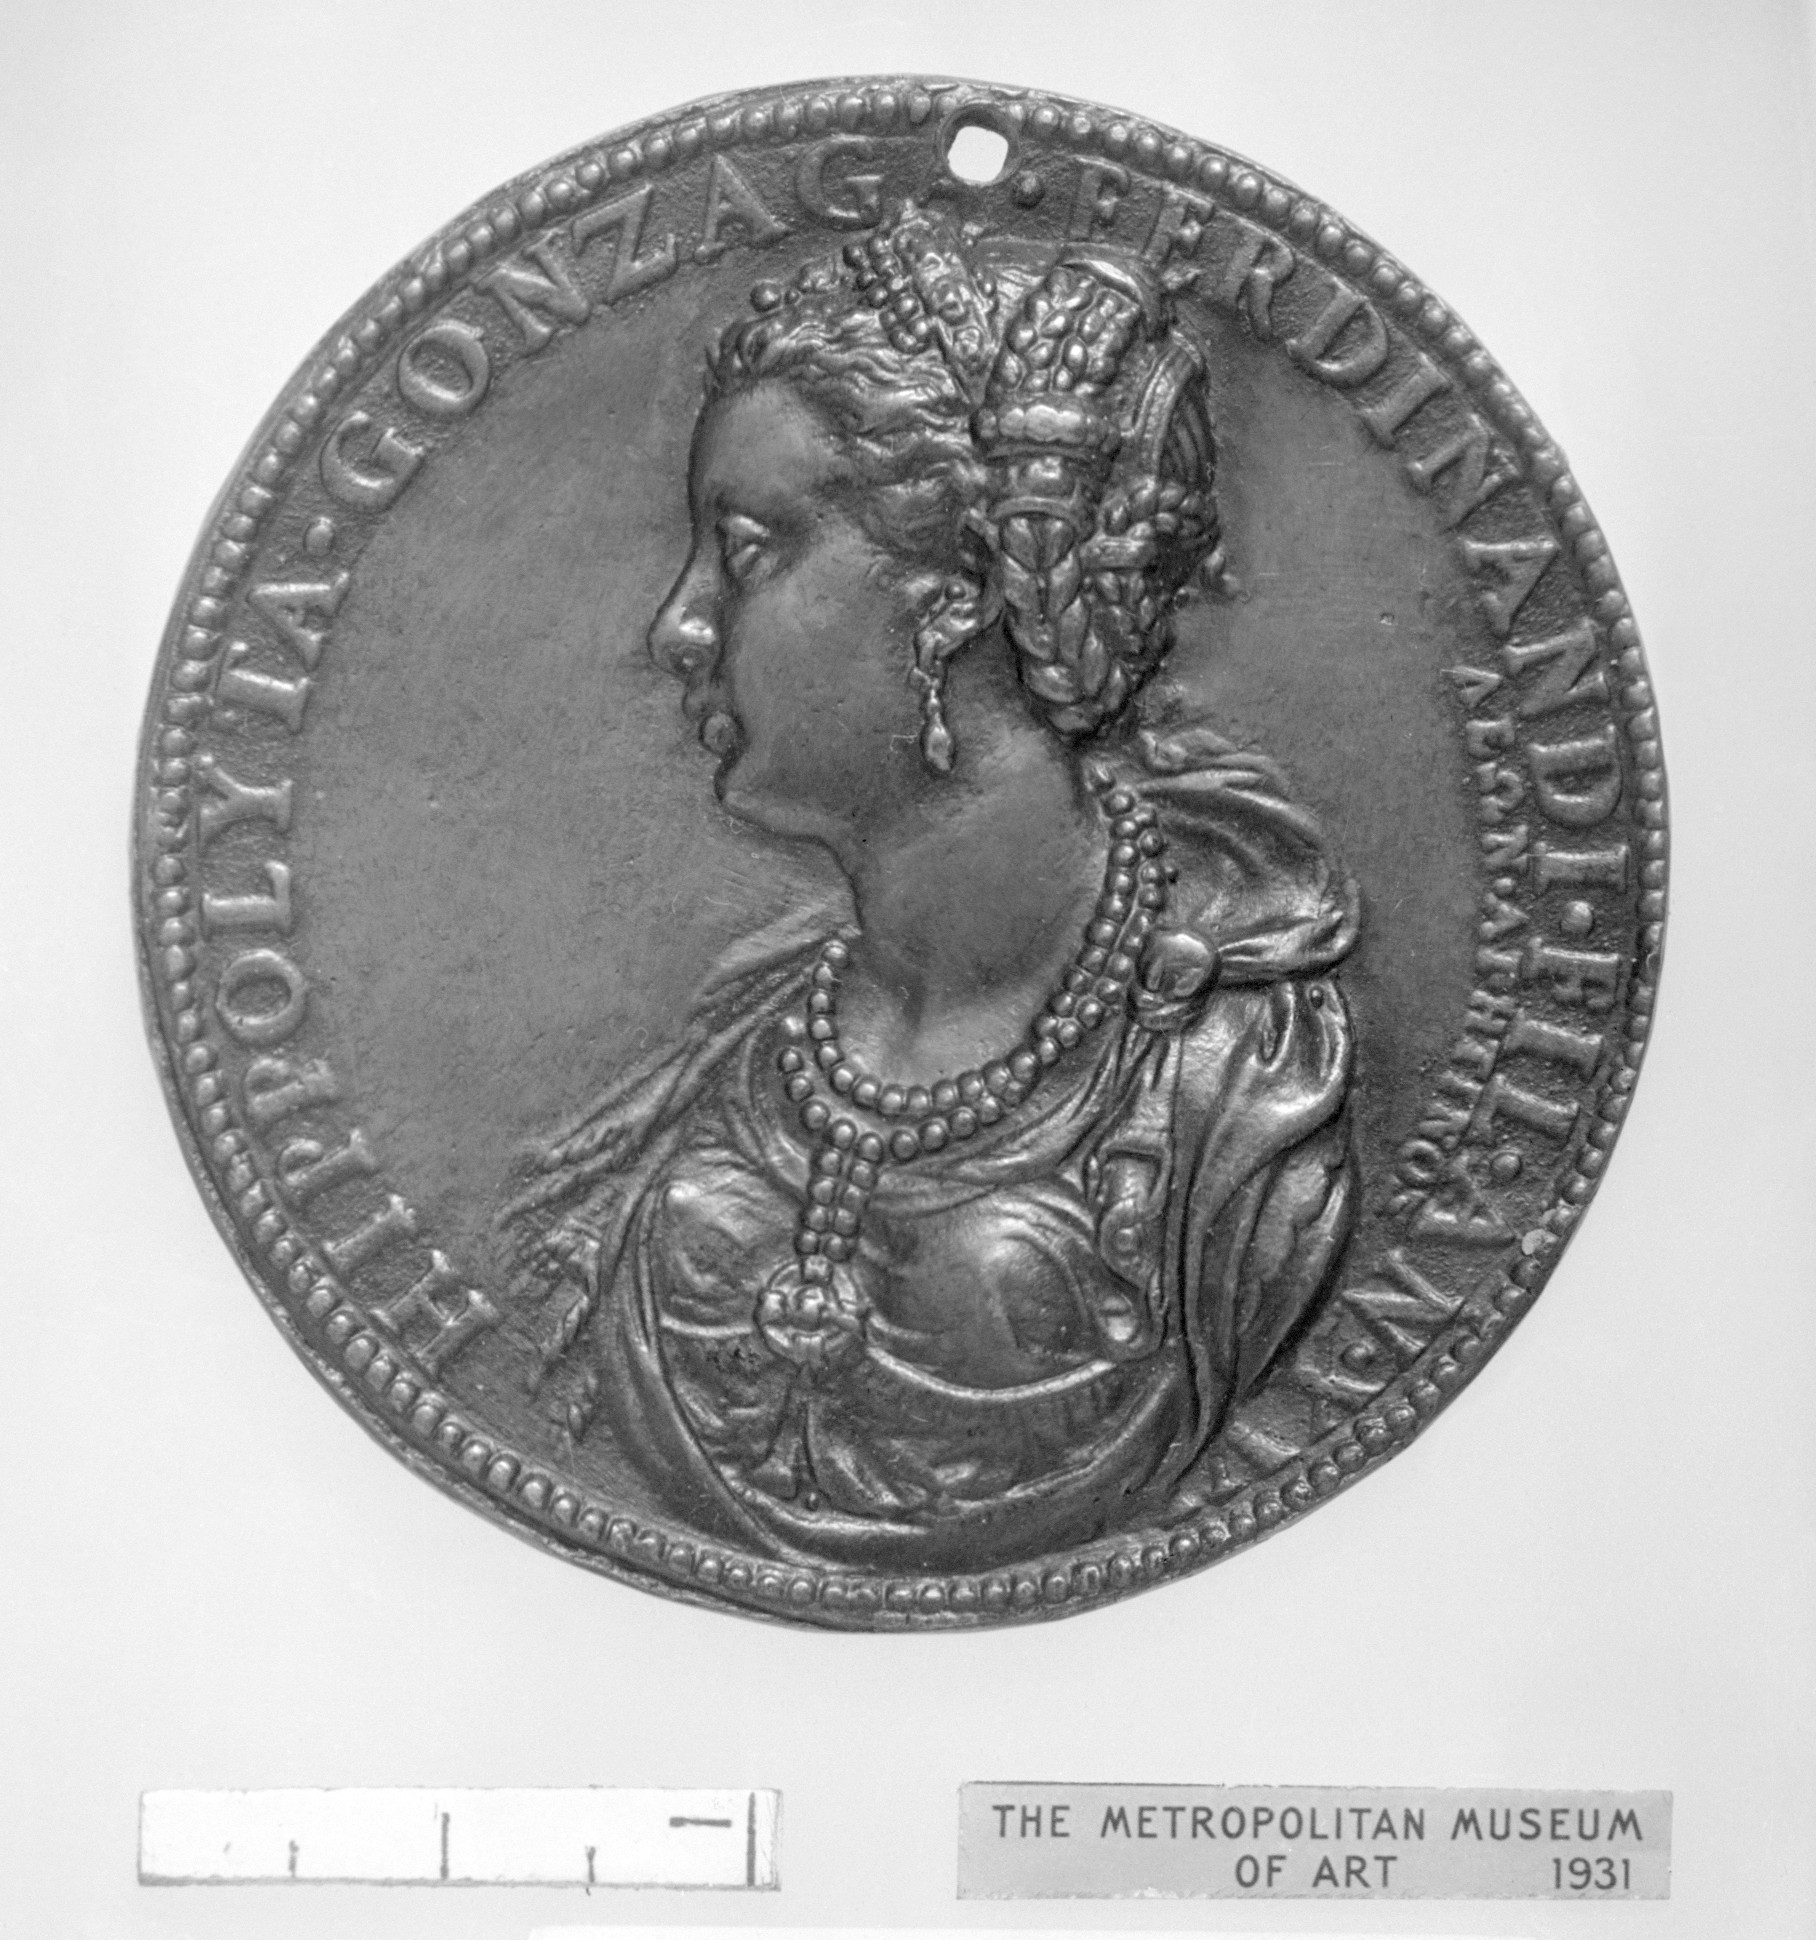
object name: medal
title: Ippolita di Ferdinando Gonzaga (1535–1563) at the age of 16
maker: leone leoni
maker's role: artist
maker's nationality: italian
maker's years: 1504-1590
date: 1551-1552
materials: bronze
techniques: casting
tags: spears,portraits,profiles,women,hunting,horns,hecate,dogs